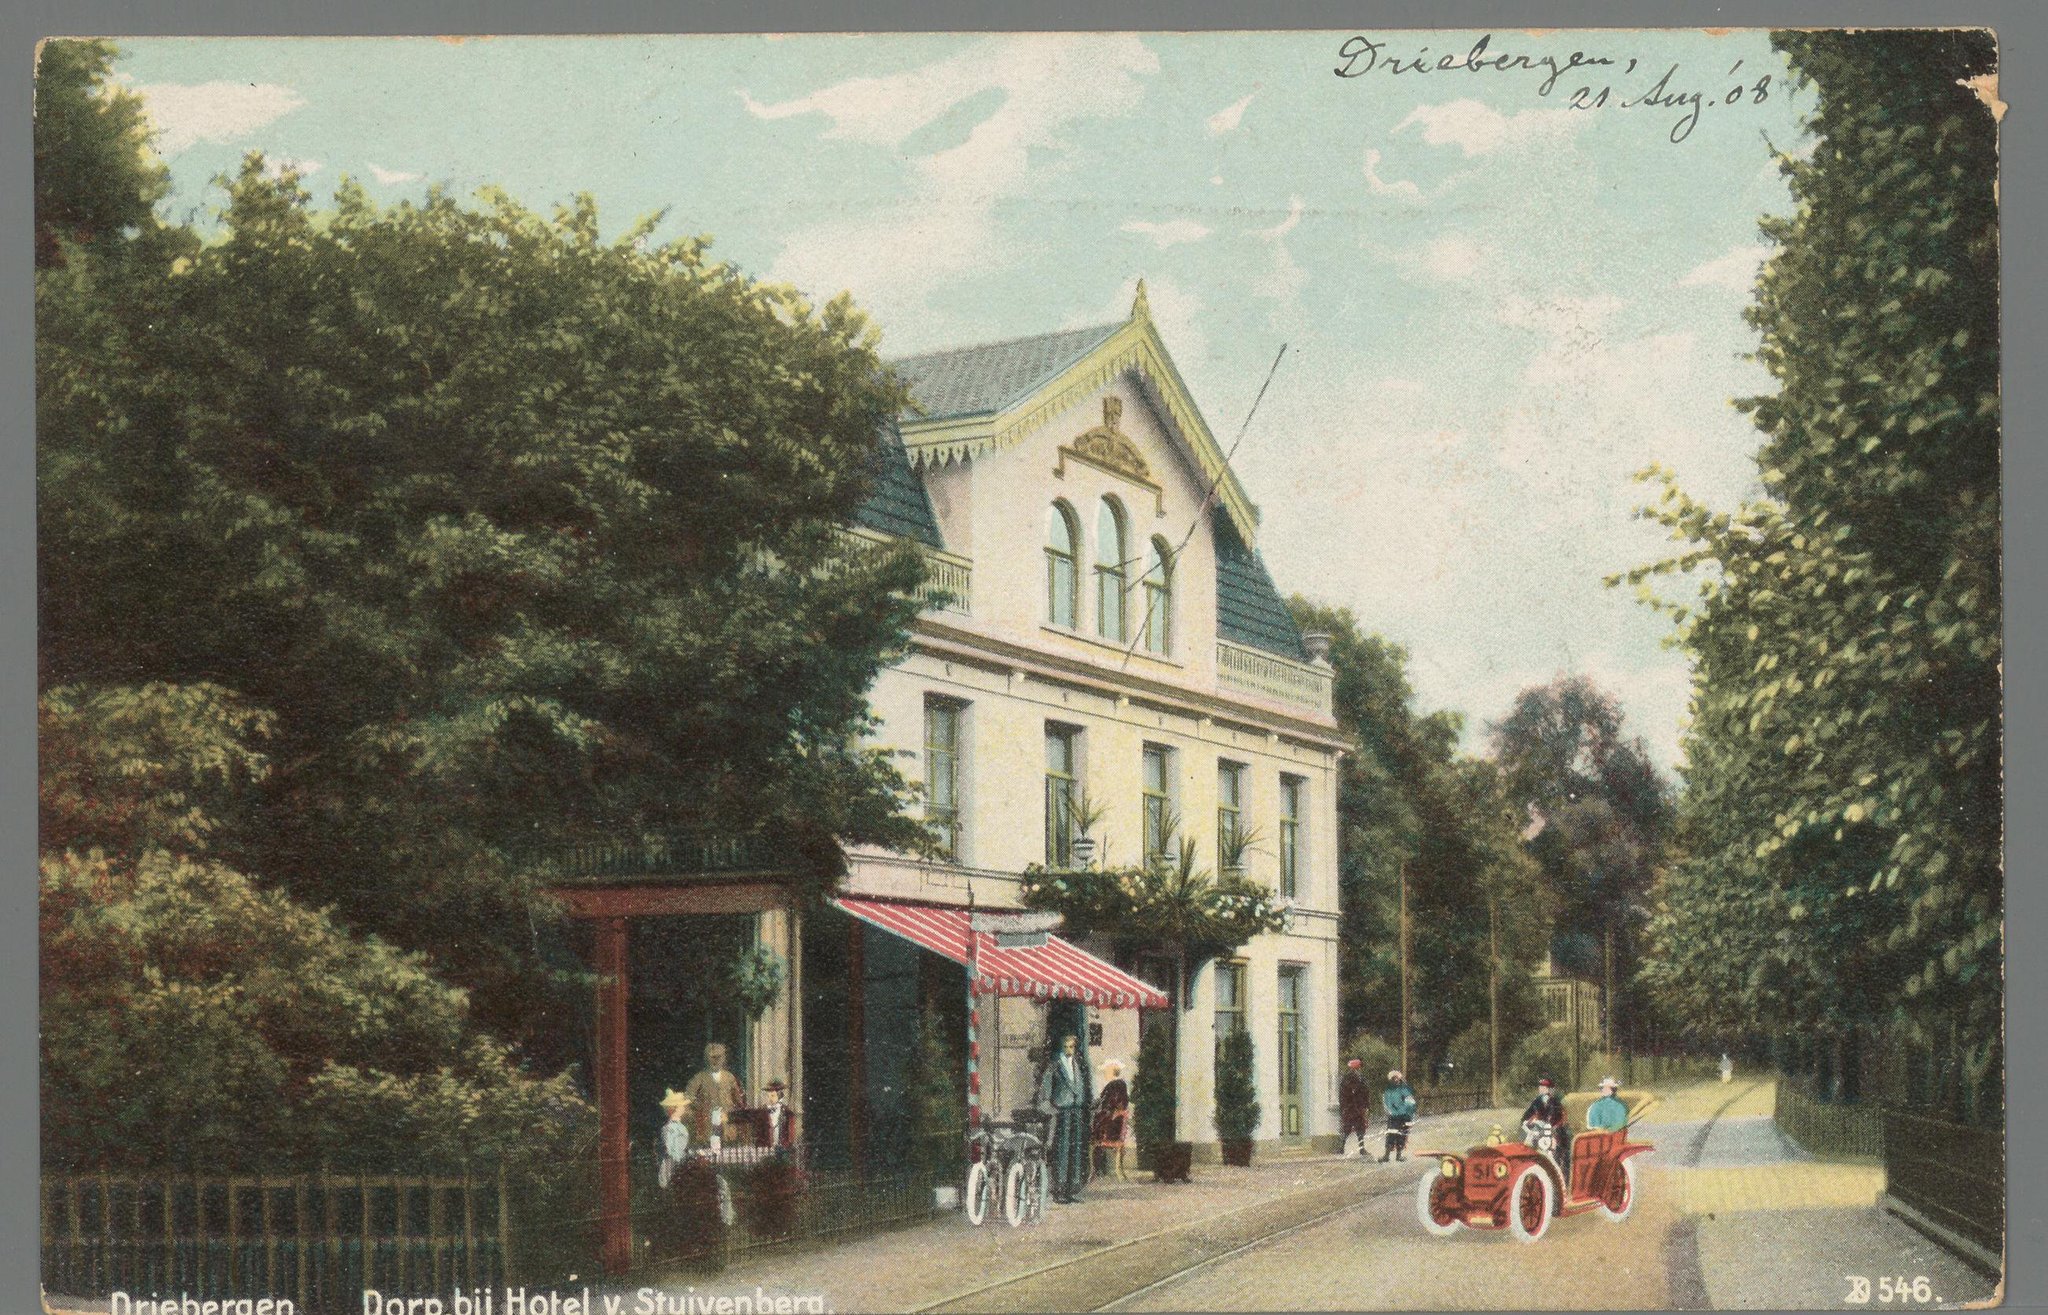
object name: photomechanical print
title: Driebergen. Dorp bij Hotel v. Stuivenberg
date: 1905-1908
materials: cardboard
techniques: lithograph, writing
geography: driebergen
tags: street, hotel, hostelry, inn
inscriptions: postage stamp